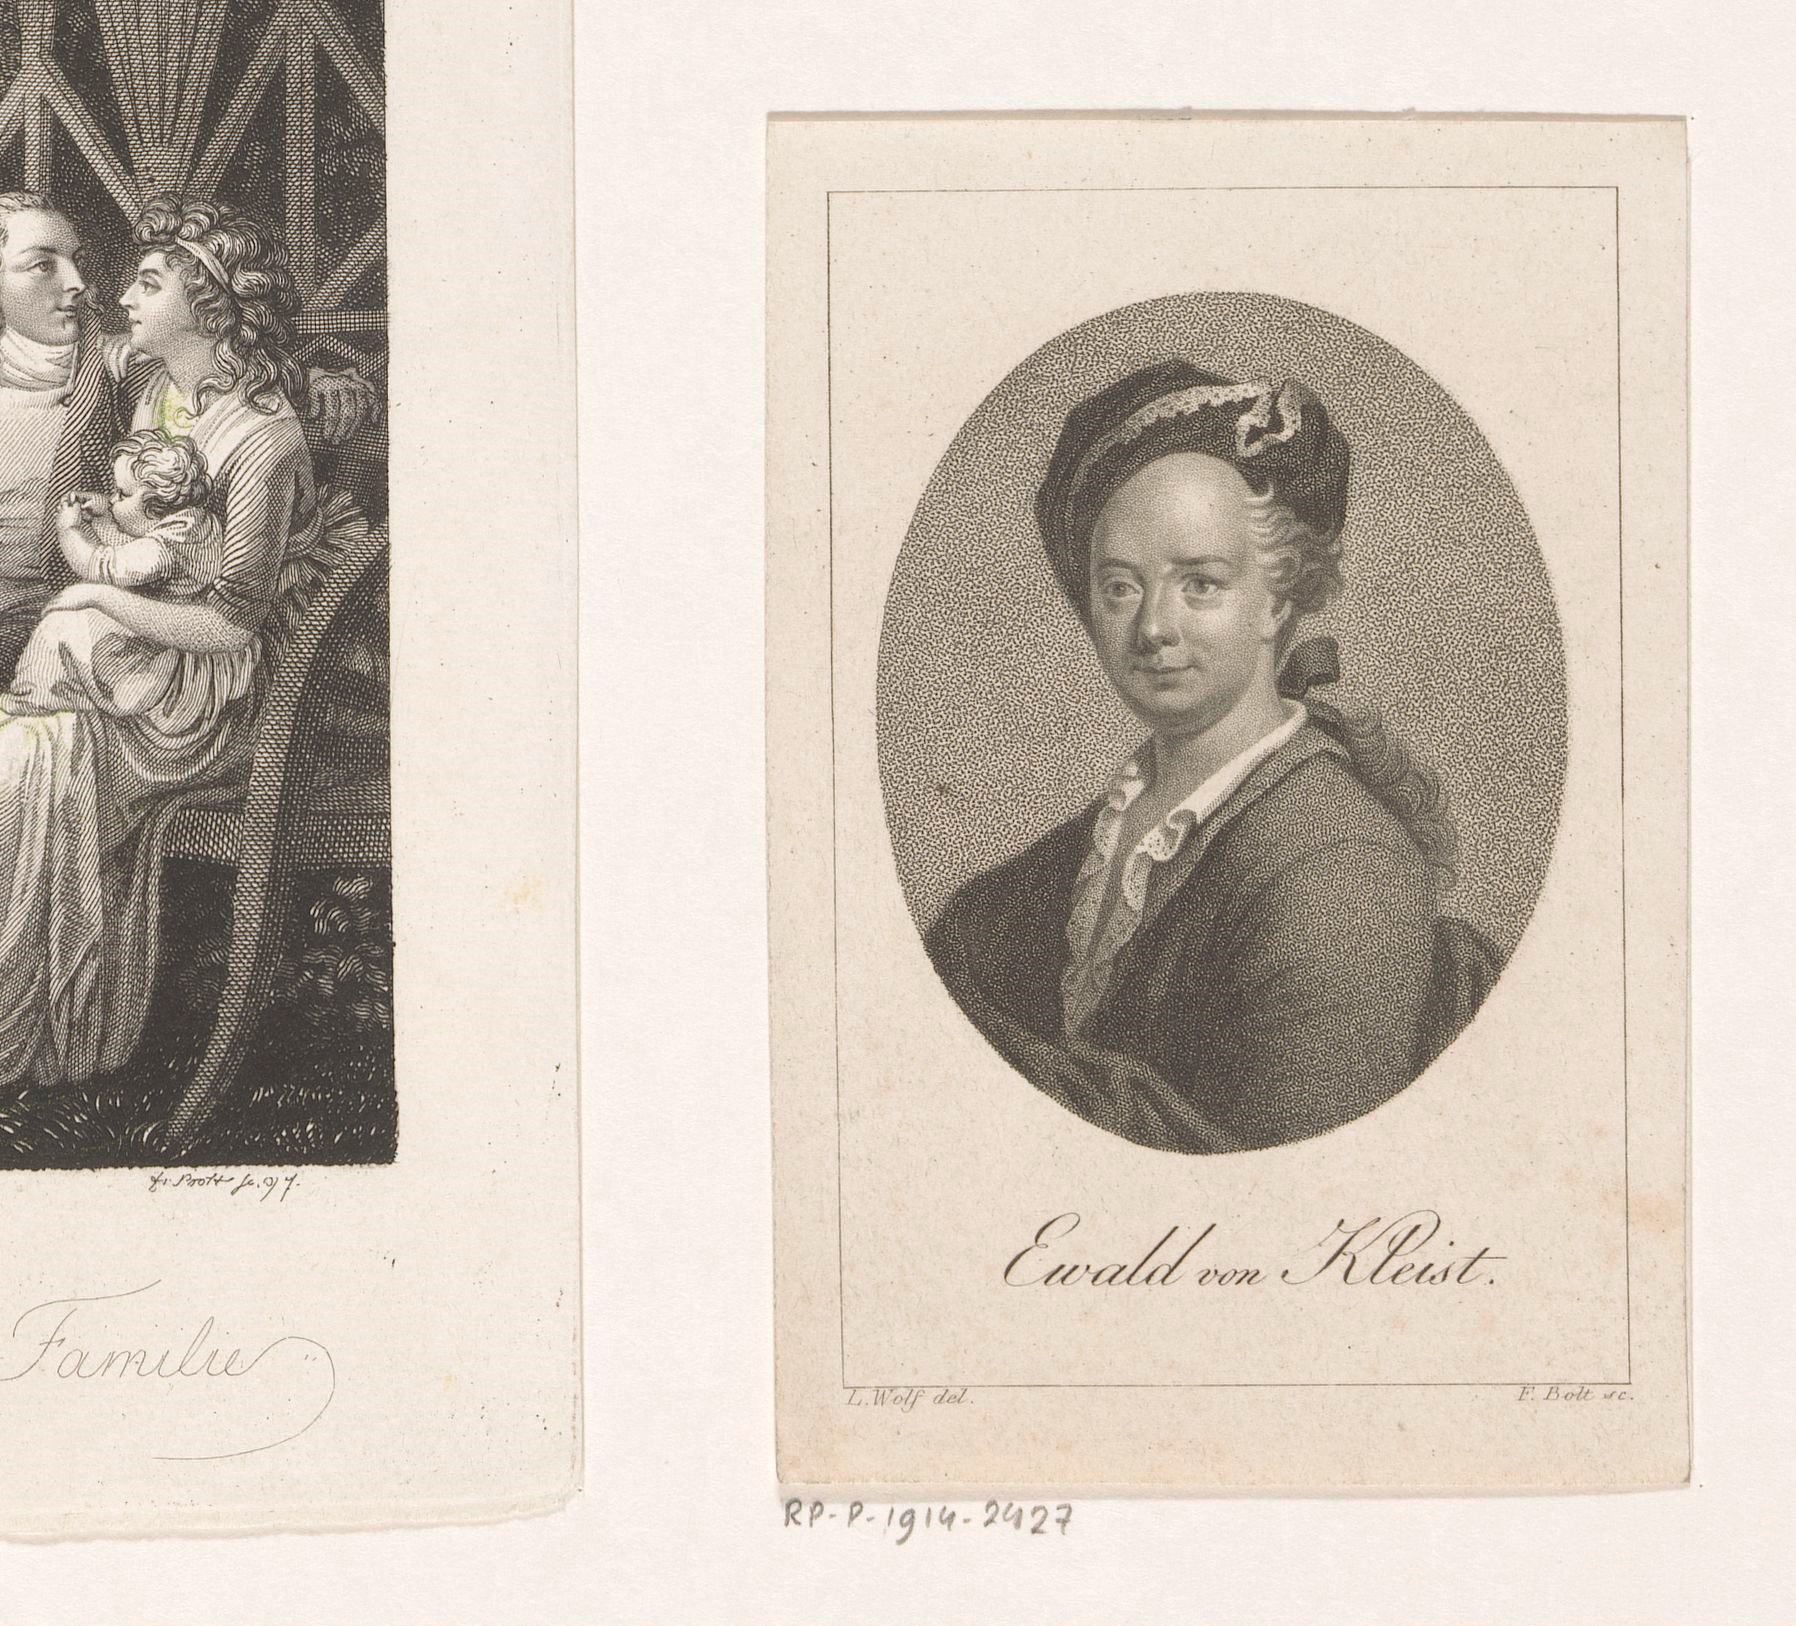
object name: print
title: Portret van Ewald Christian von Kleist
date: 1779-1836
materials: paper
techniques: stippling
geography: berlin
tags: historical persons, writer, poet, author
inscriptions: collector's mark: Lugt 2228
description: Prent waarschijnlijk gebruikt als boekillustratie.